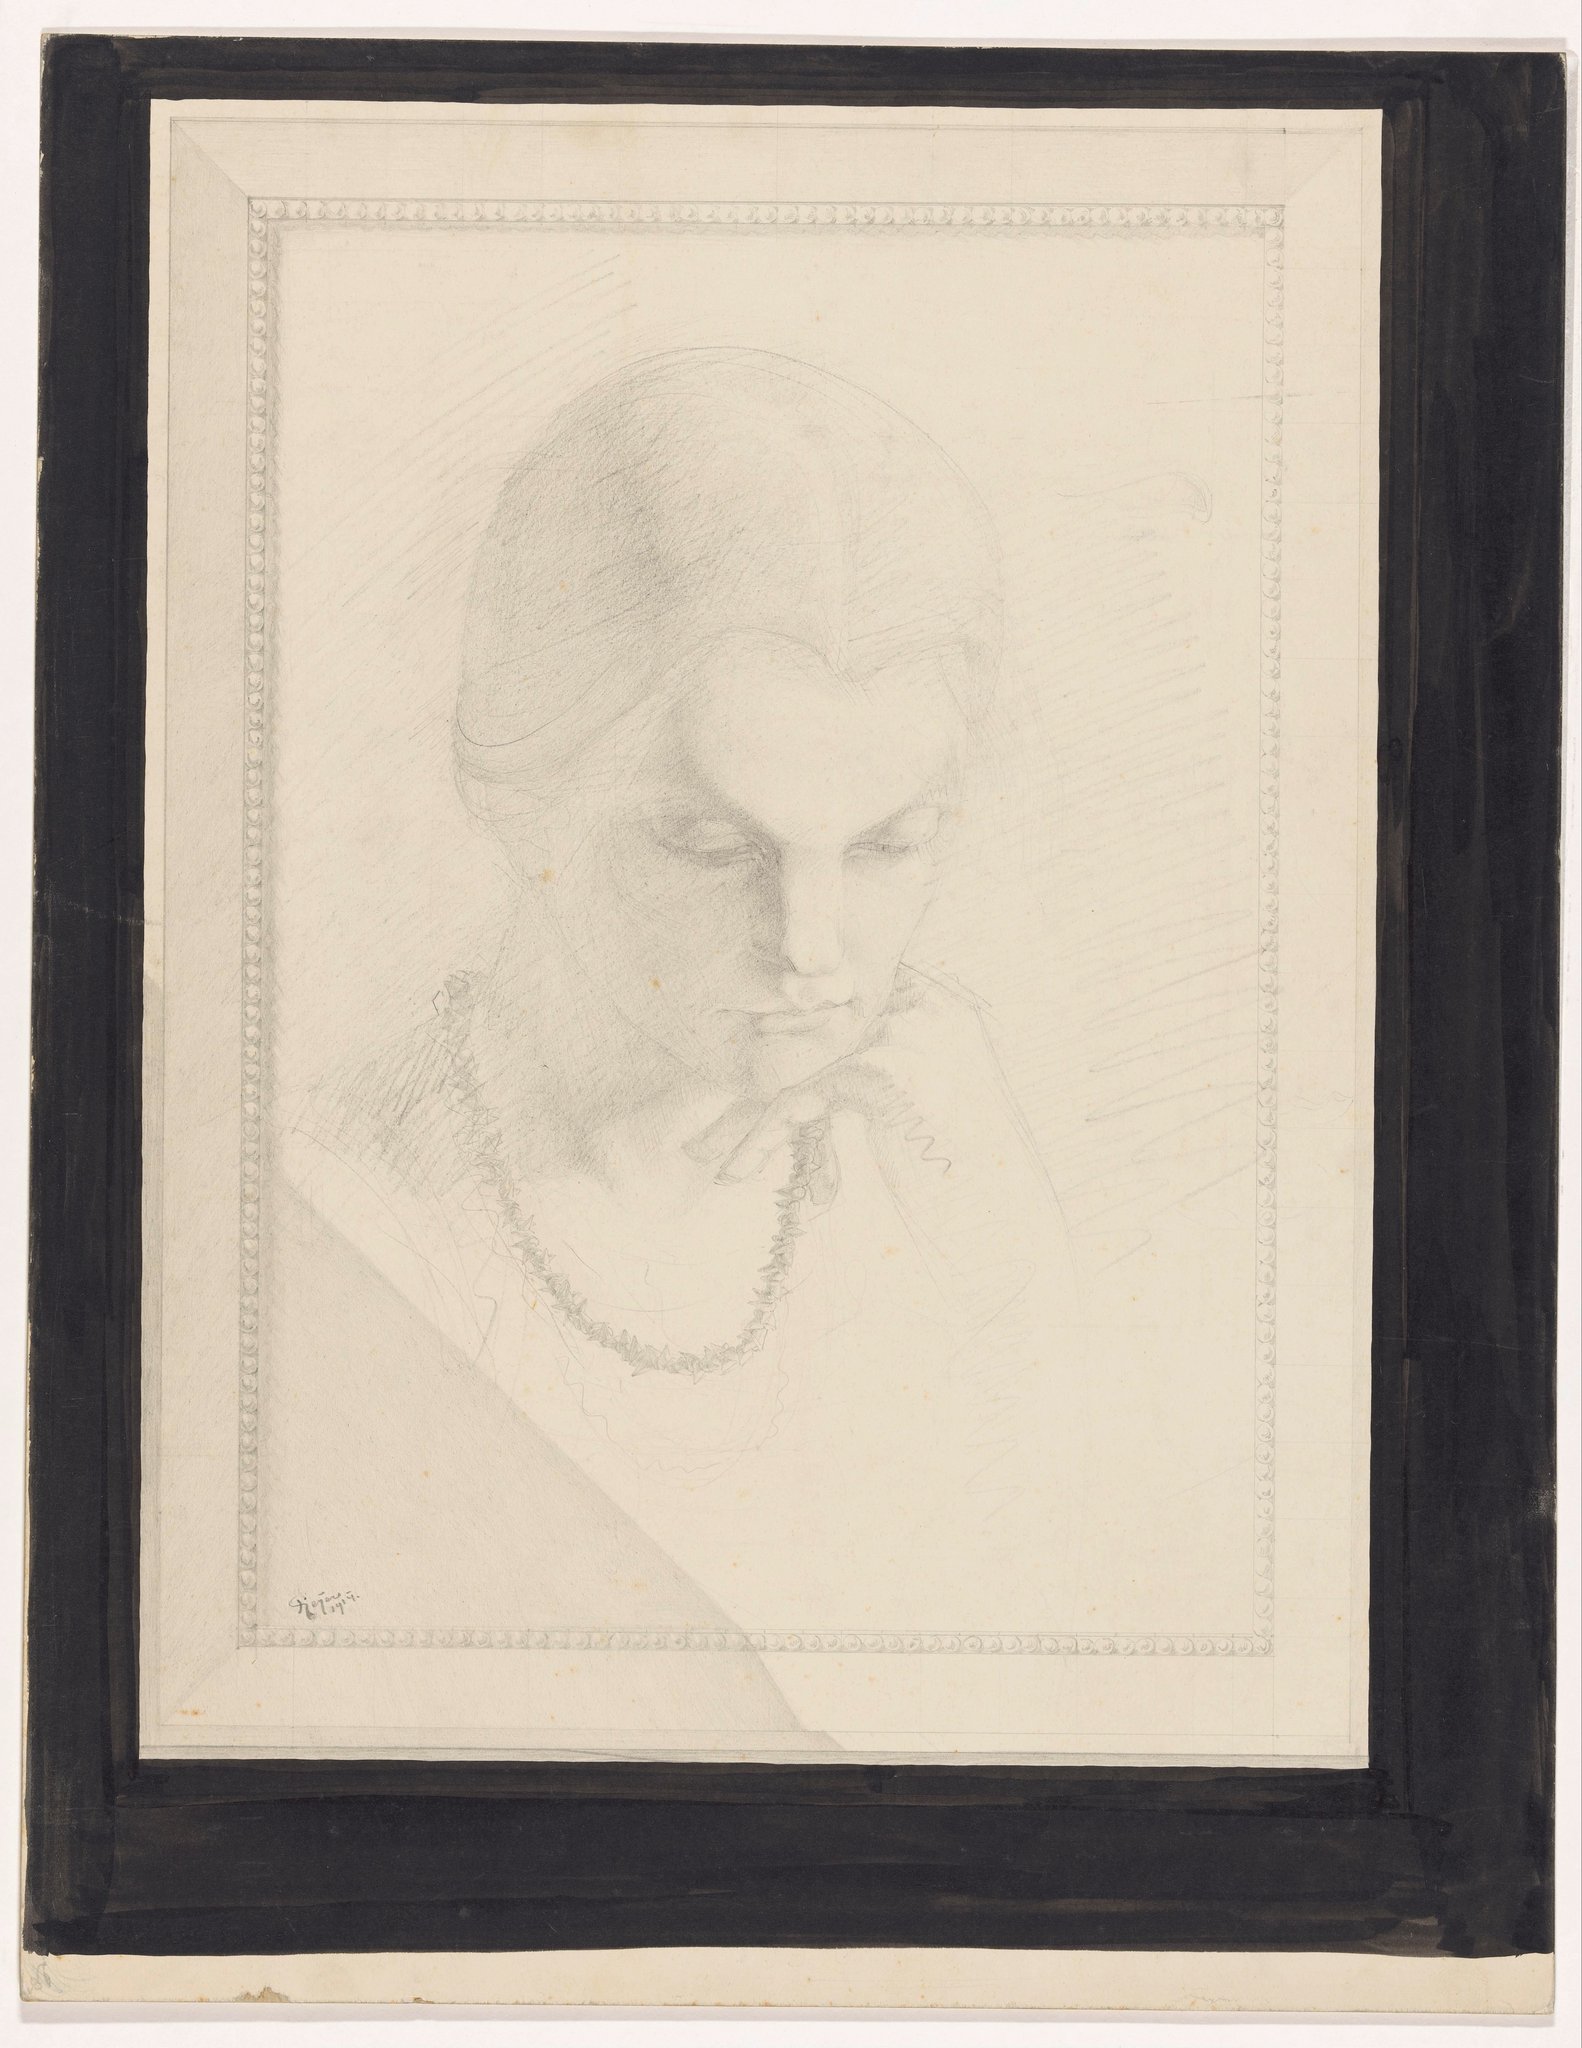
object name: drawing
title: Portret van een onbekende peinzende vrouw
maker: reijer stolk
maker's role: draughtsman, print maker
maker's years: 1896-1945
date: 1914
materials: ink, paper, pencil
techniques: brush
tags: historical persons not known by name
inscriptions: collector's mark: Lugt 2228